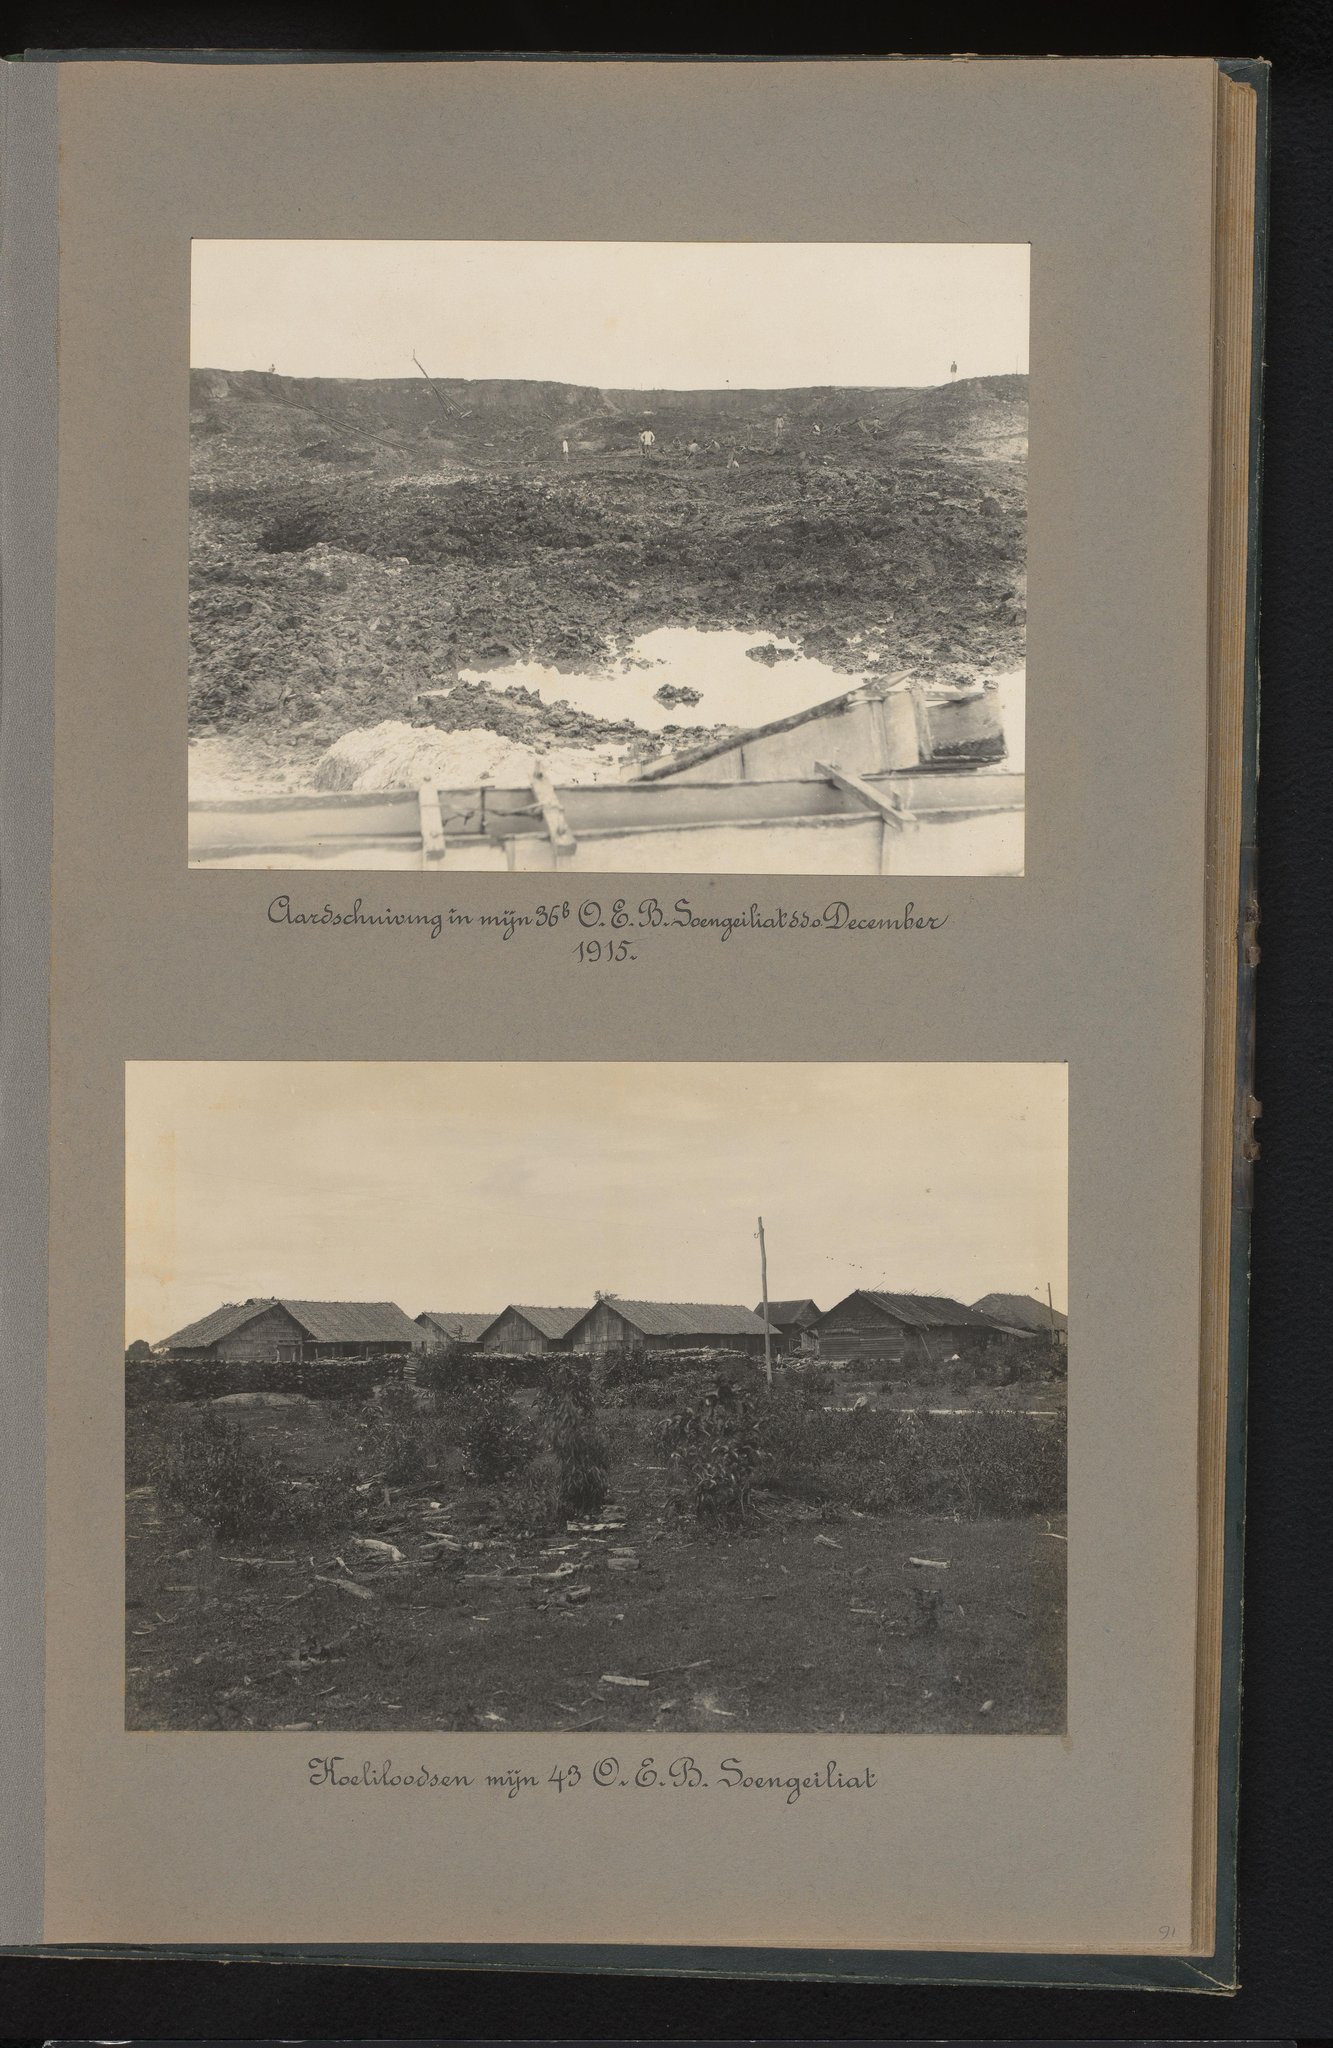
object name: photograph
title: Aardverschuiving in een mijn en woningen van contractarbeiders van de Banka-tinwinning te Soengeiliat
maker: Anonymous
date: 1914-1919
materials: cardboard, photographic support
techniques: gelatin silver print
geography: bangka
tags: robert julius boers, colonial system, opencast mine; strip mining, landslide, hut, cabin, lodge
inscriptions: inscription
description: Albumblad met 2 foto's van een aardverschuiving in 1915 en van woningen van contractarbeiders van de Banka-tinwinning te Soengeiliat. Onderdeel van het fotoalbum aangeboden aan Robert Julius Boers bij zijn vertrek naar Nederland in 1919 door het personeel van de Banka-tinwinning.